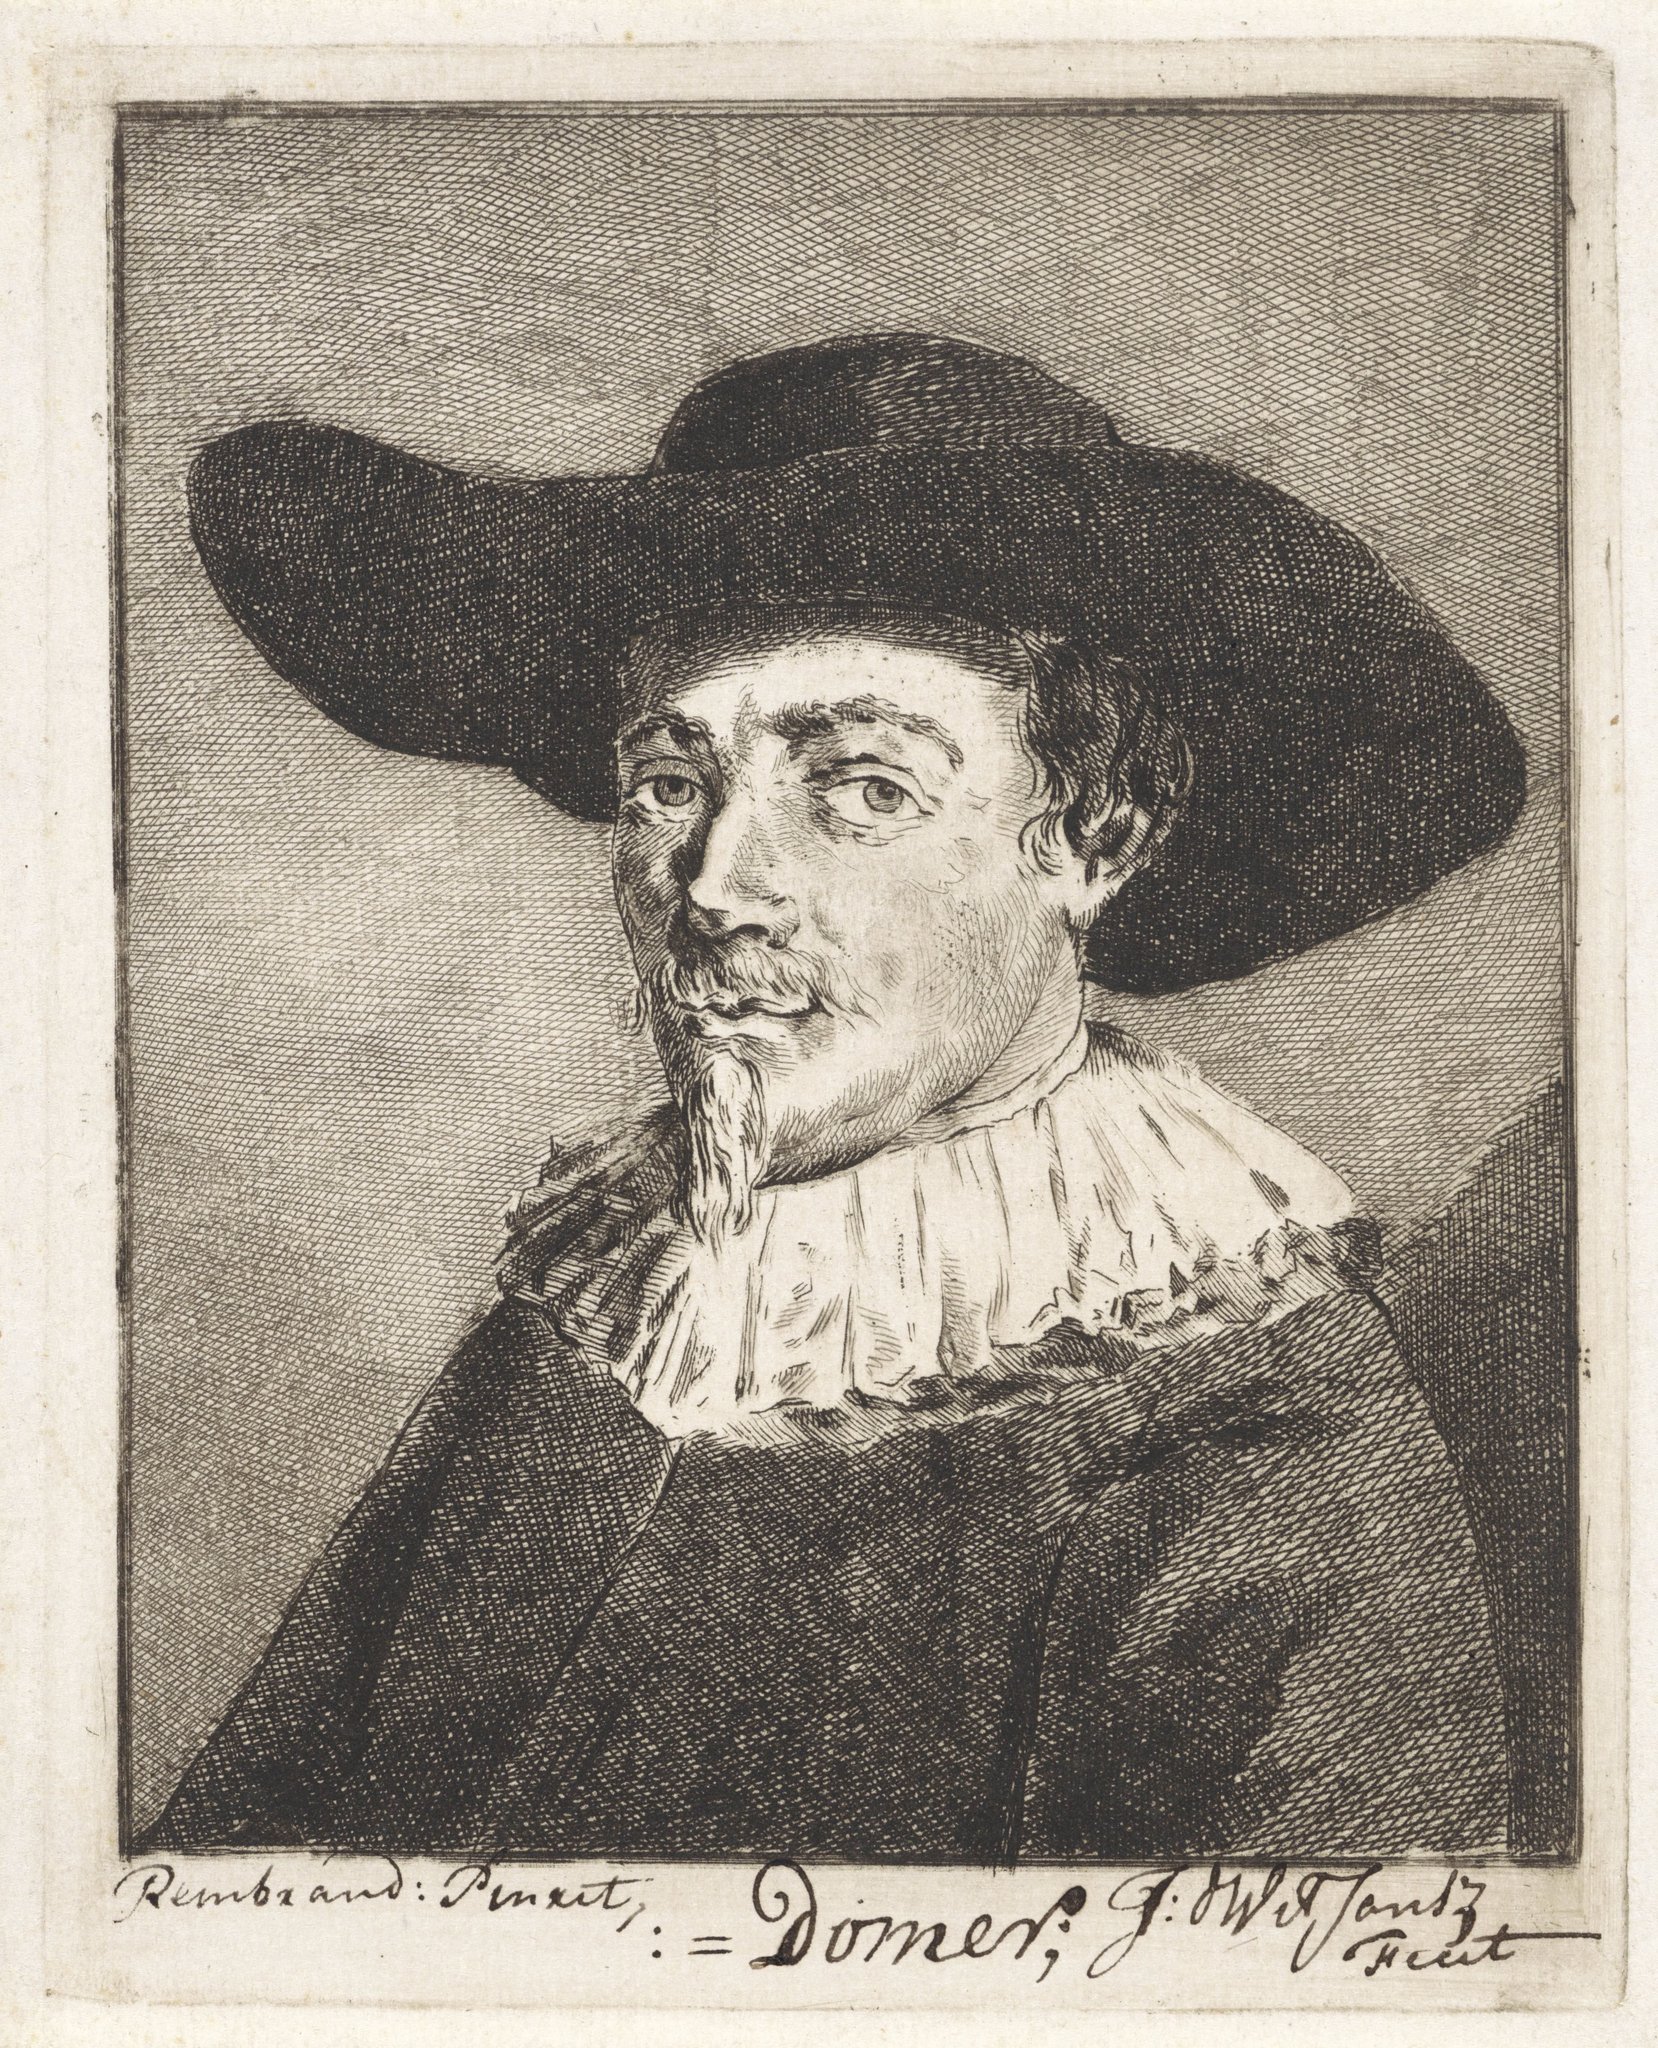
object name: print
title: Portret van de schilder Jacques Domer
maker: rembrandt van rijn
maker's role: draughtsman, painter, print maker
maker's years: 1606-1669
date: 1754-1809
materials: paper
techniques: etching, pen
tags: draughtsman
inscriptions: collector's mark: Lugt 2228, collector's mark: Lugt Lugt 2760